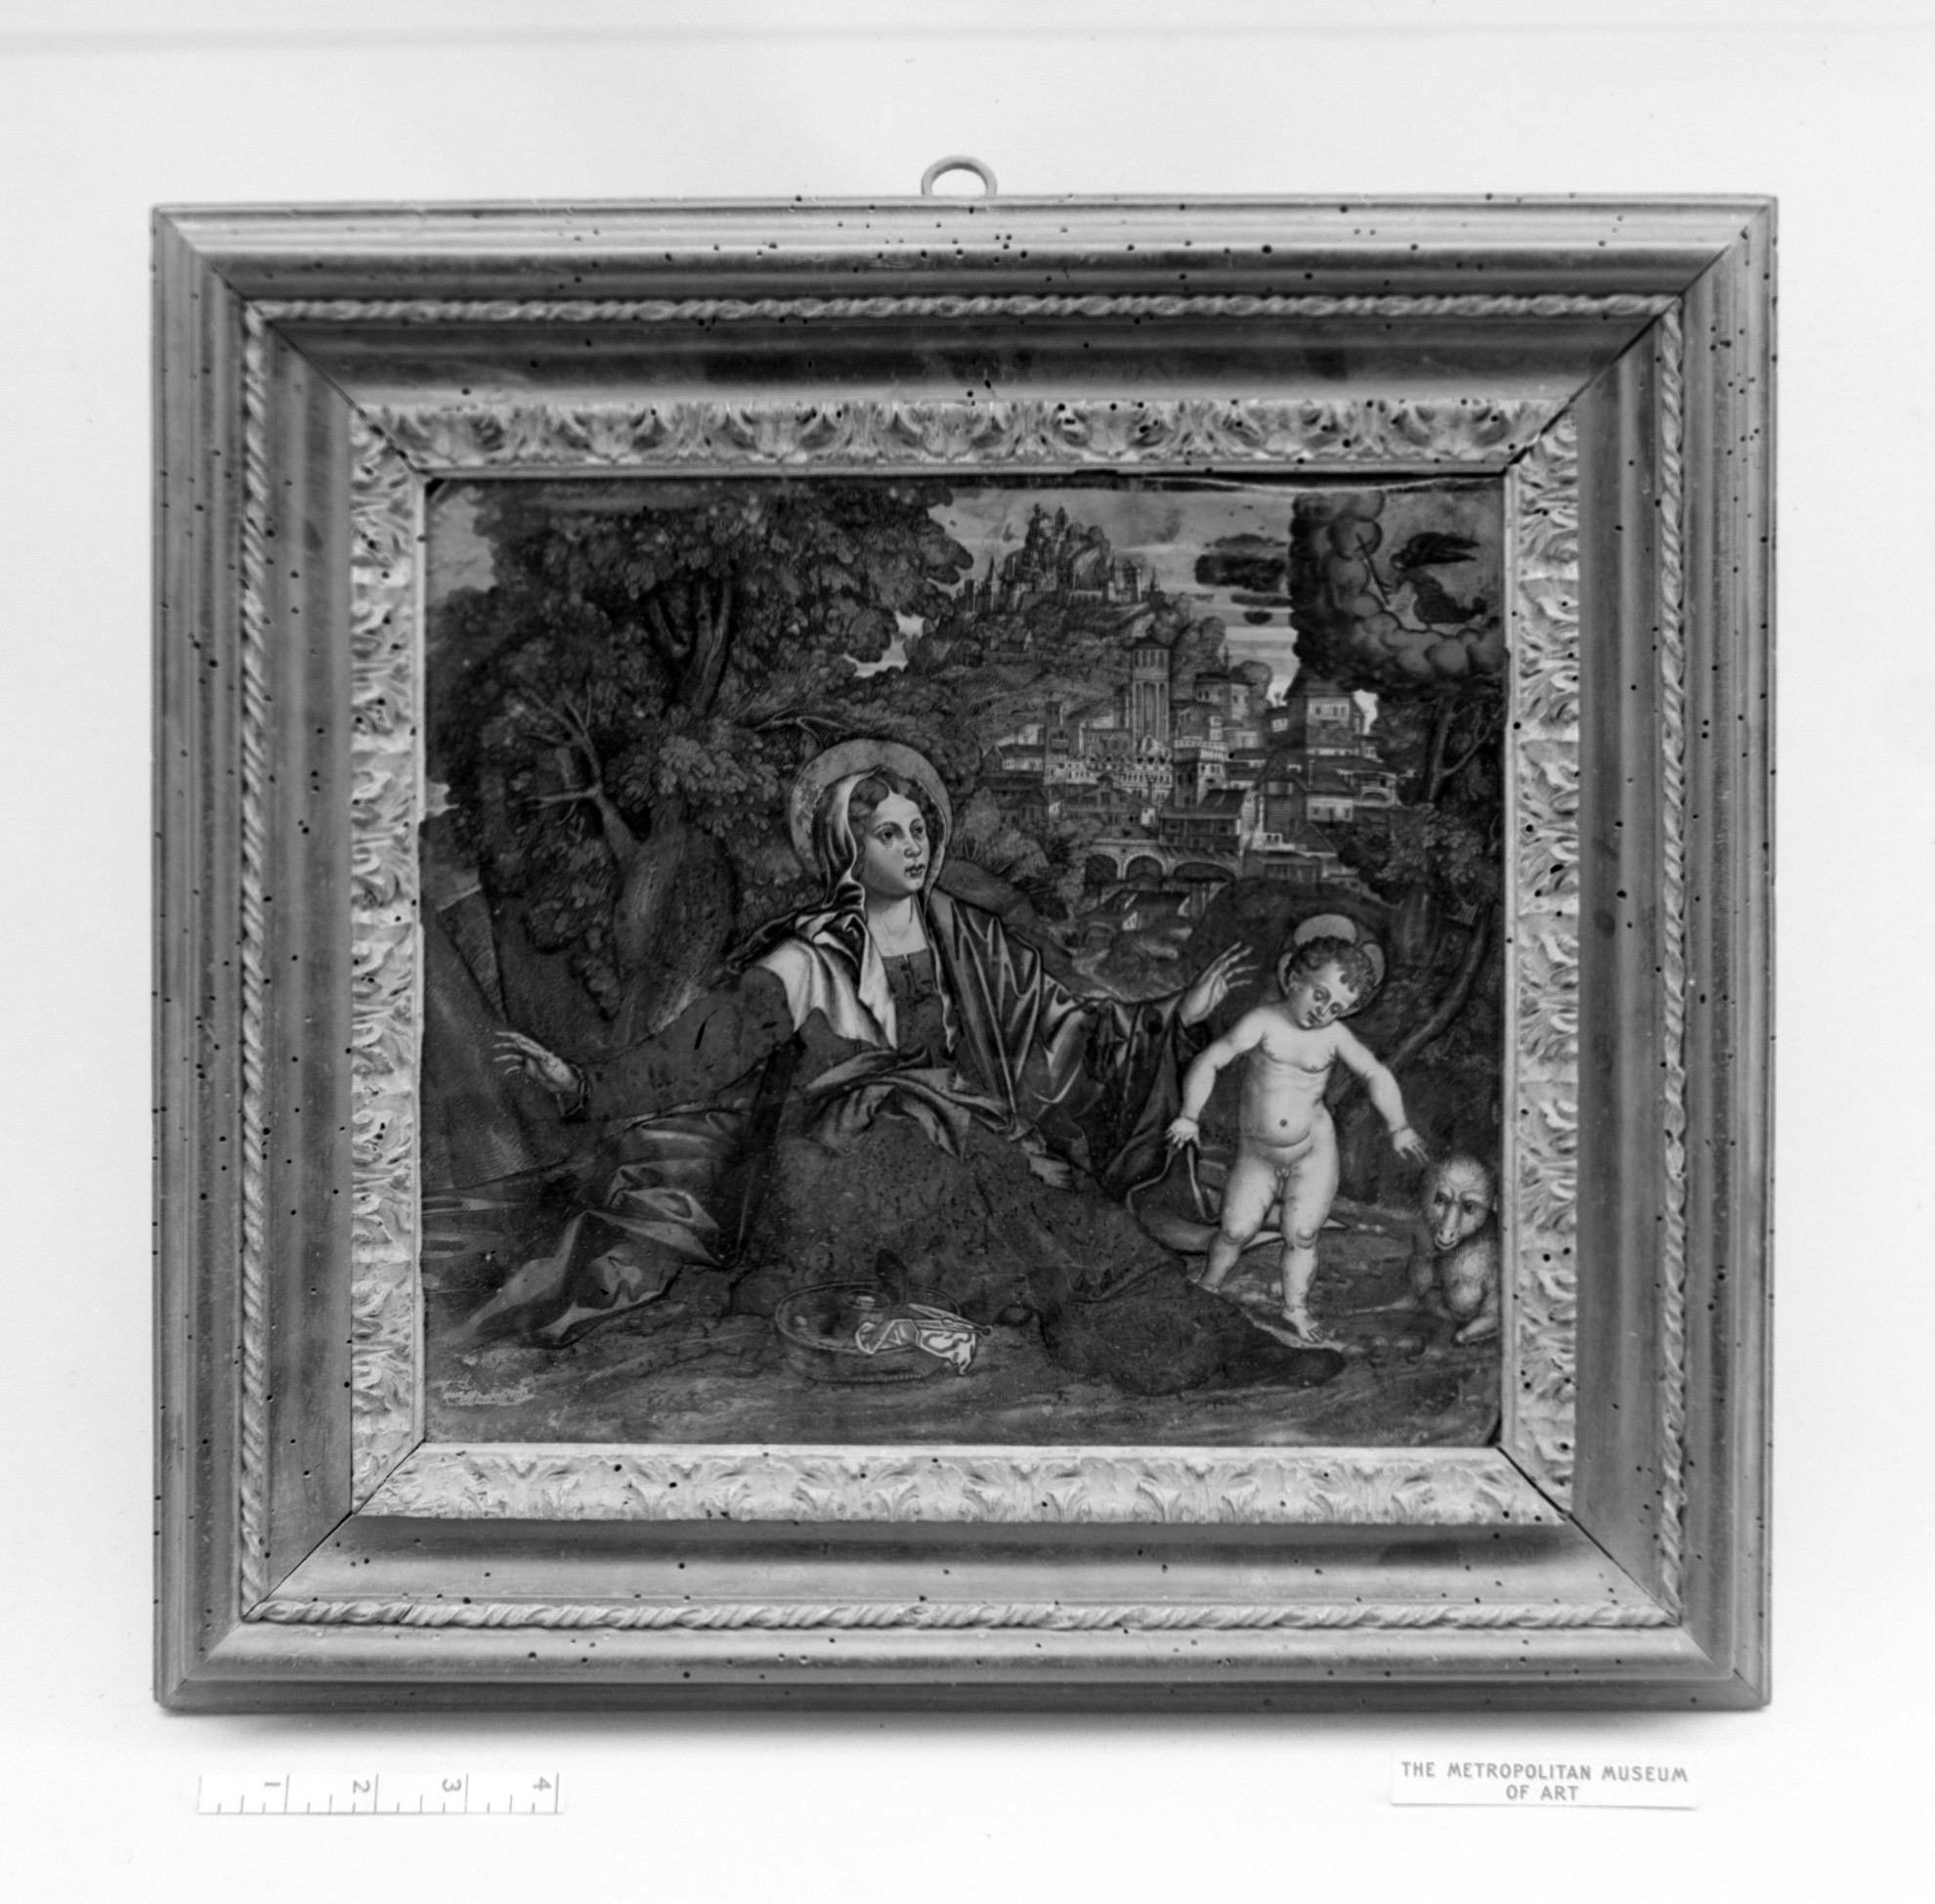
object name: panel or plaque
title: Virgin seated in landscape with Christ Child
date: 1501-1600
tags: landscapes,christ,virgin mary,jesus